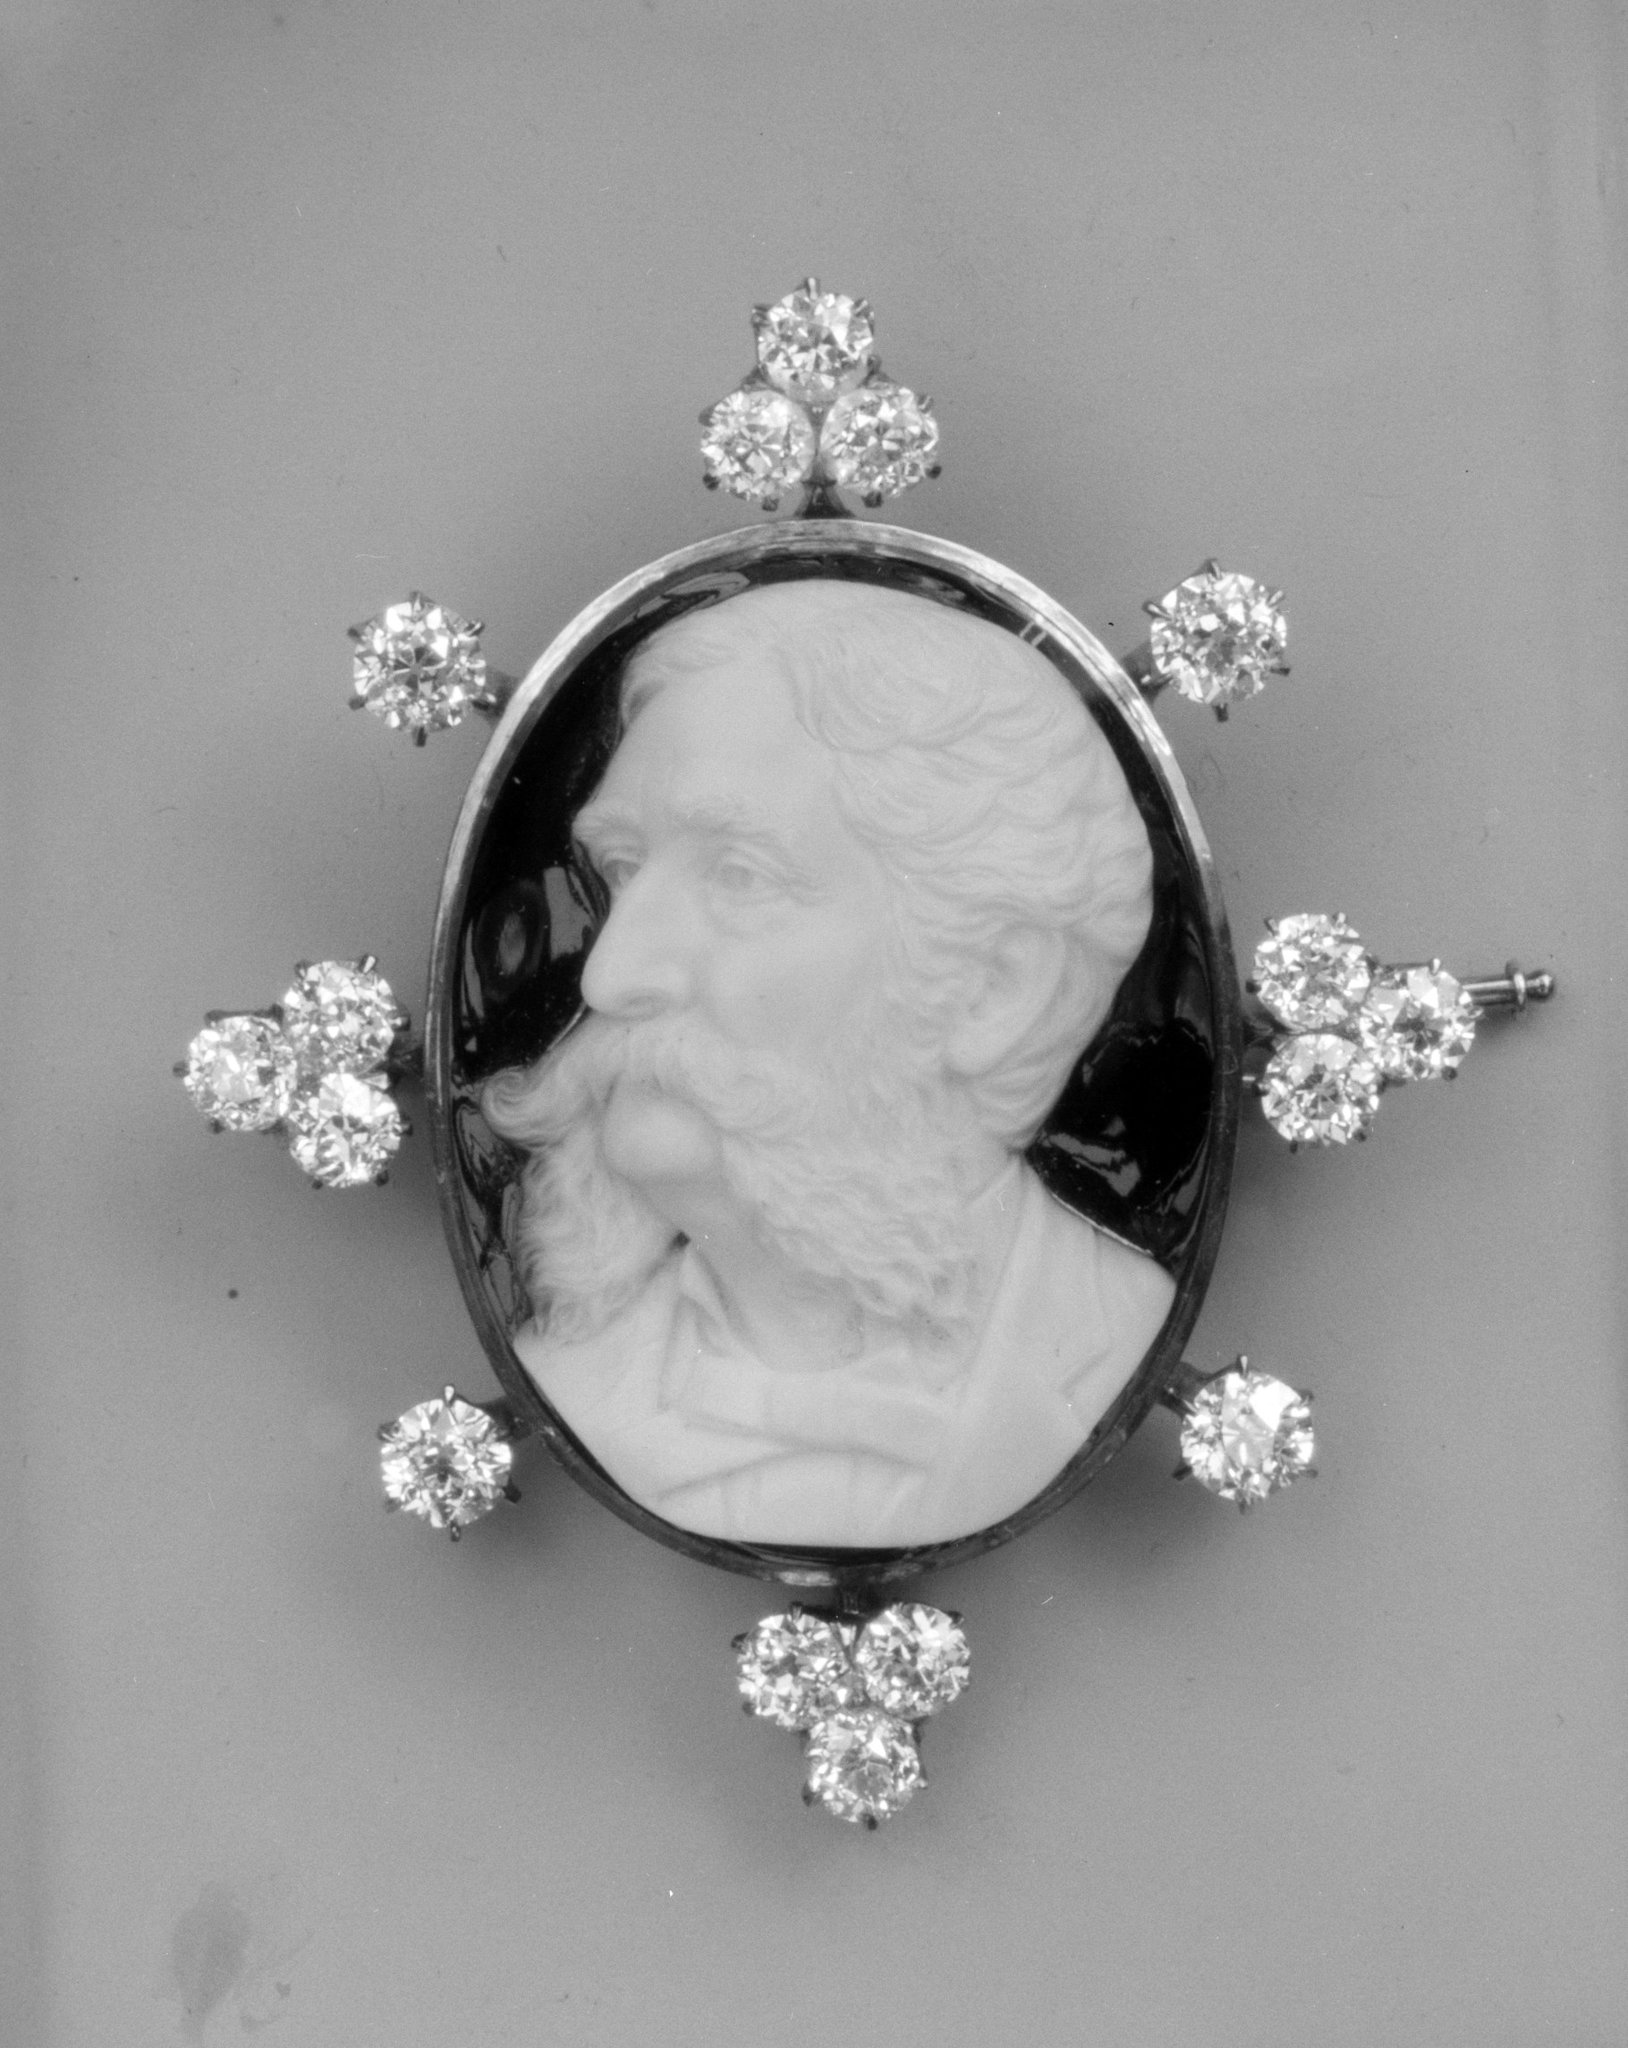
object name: brooch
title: Cameo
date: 1860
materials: diamond, gold, onyx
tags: men,portraits,profiles